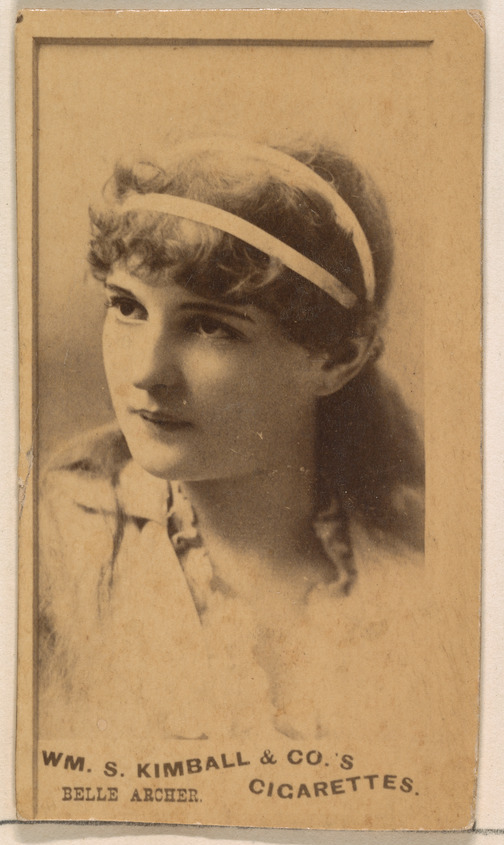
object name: photograph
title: Belle Archer, from the Actresses series (N203) issued by Wm. S. Kimball & Co.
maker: william s. kimball & company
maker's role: publisher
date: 1889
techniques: color lithograph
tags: portraits,women,actresses